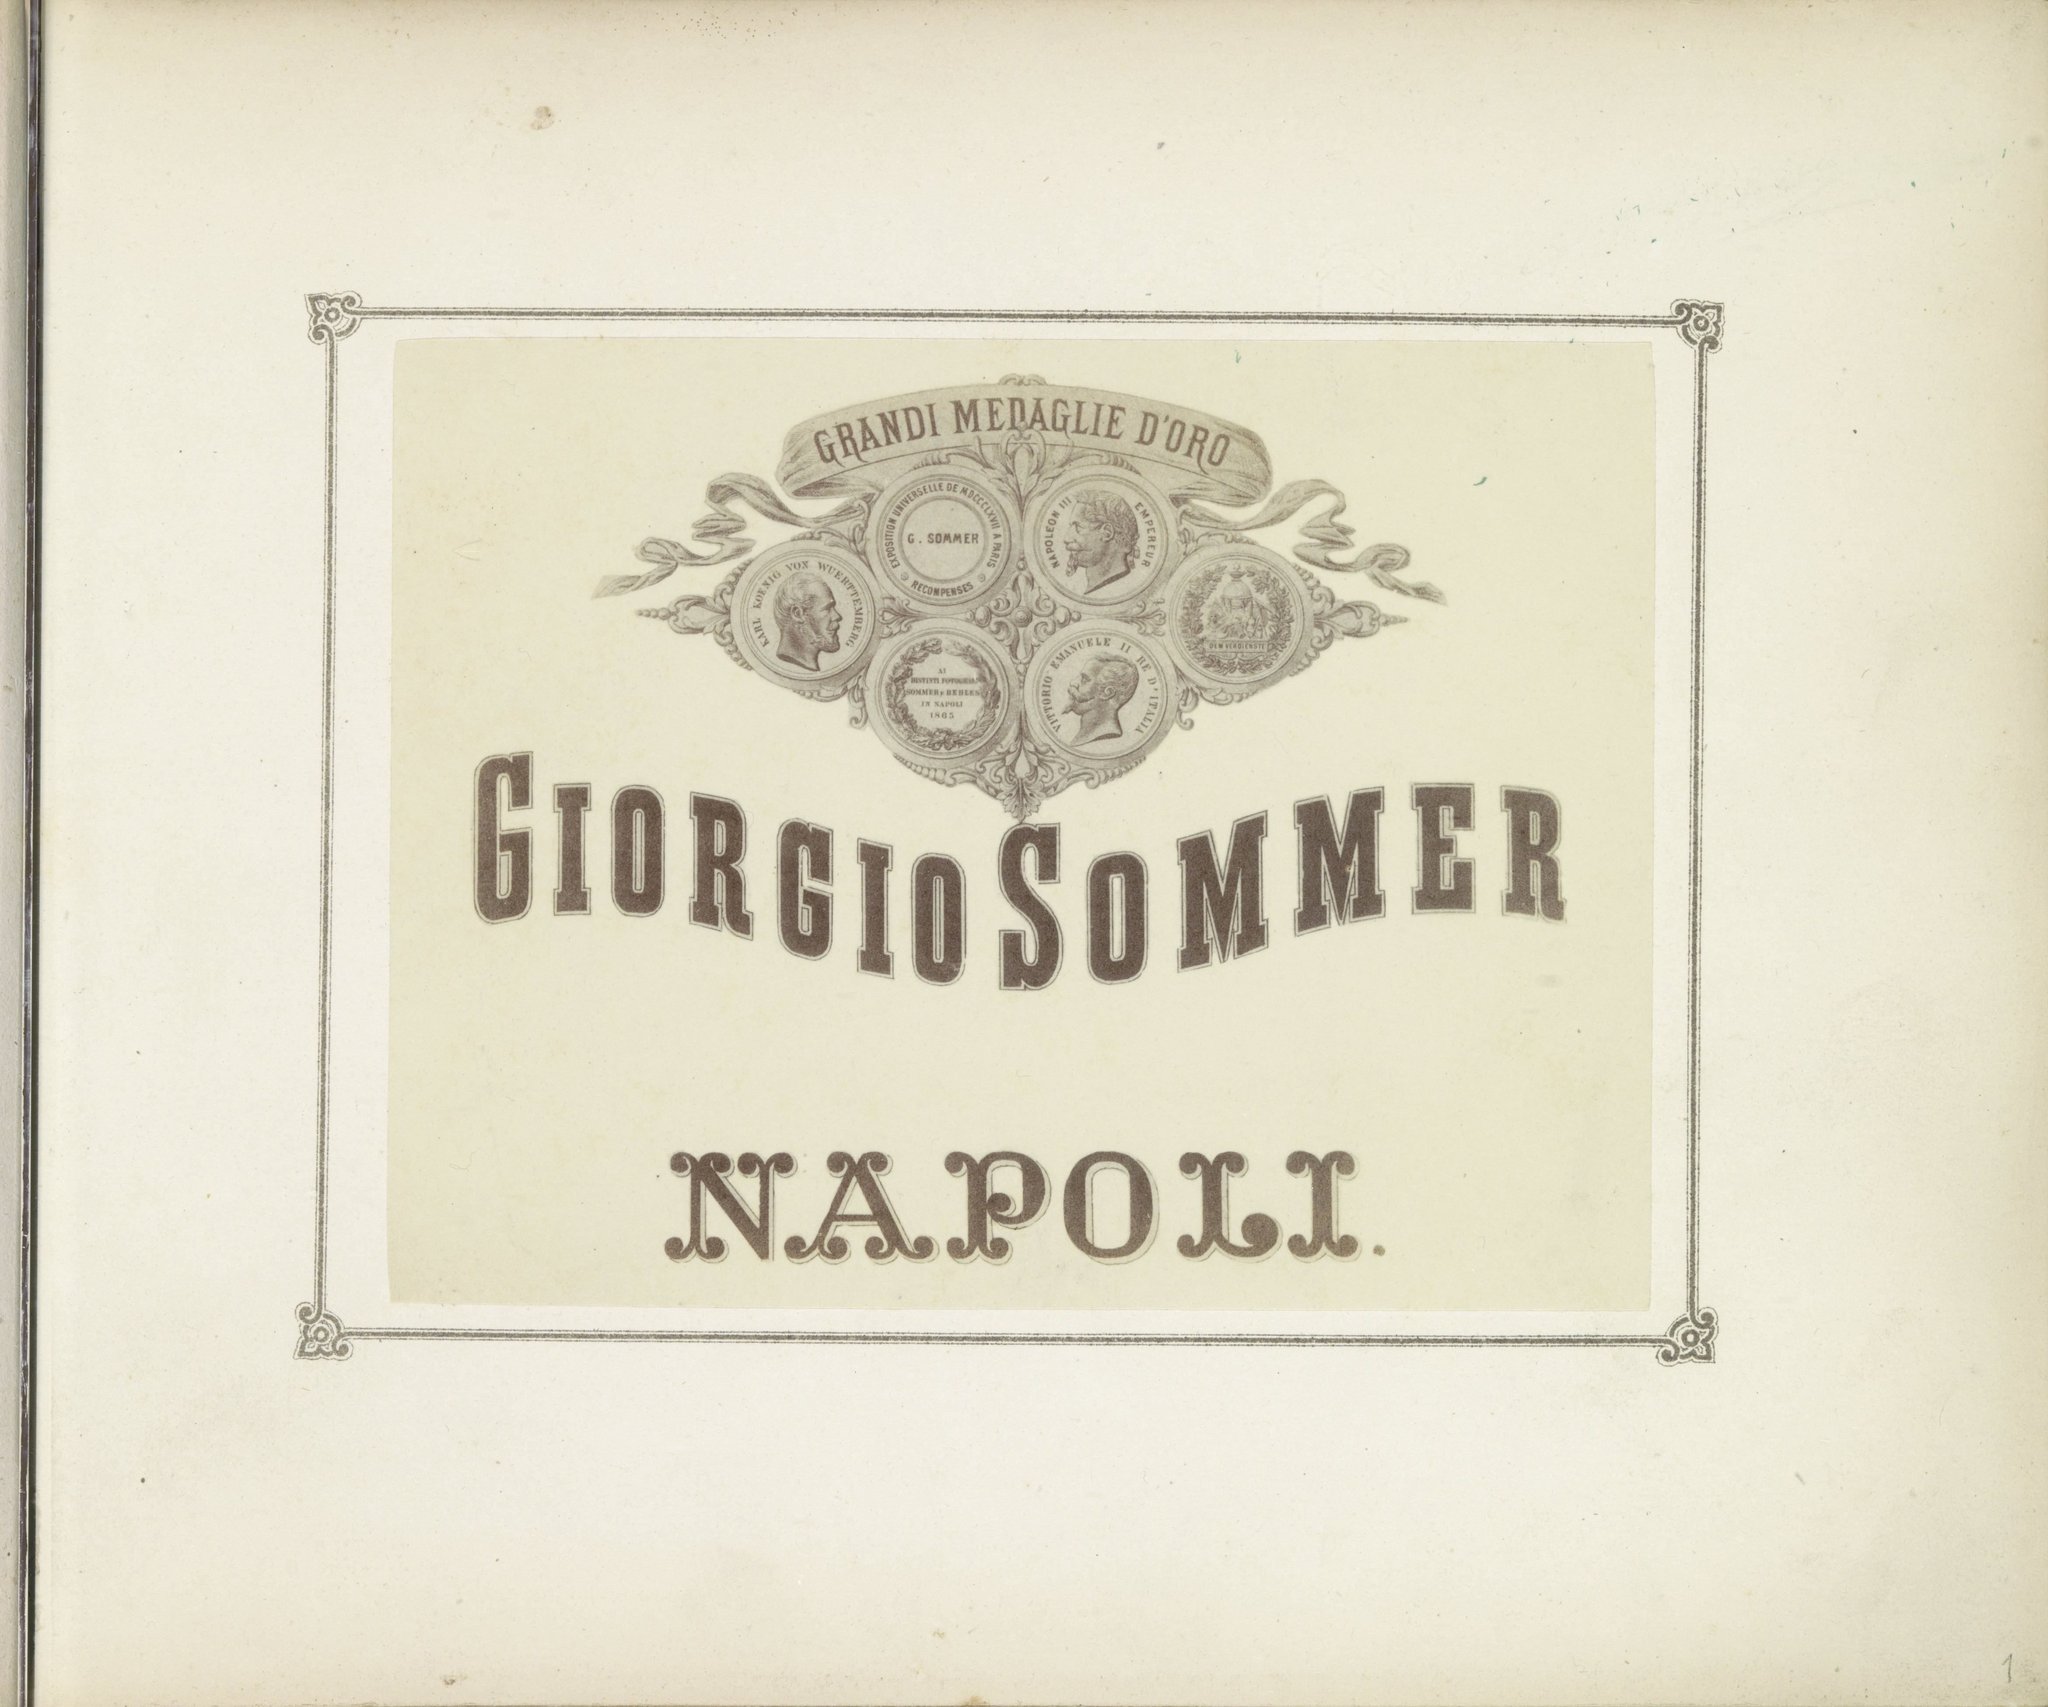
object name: photograph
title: Pagina met de vervaardigersnaam, zijn vestigingsplaats en gewonnen fotografieprijzen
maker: giorgio sommer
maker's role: fotograaf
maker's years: 1834-1914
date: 1860-1900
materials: paper, photographic support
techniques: albumen print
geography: pompeii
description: Onderdeel van Fotoalbum met opnames van opgravingen in Pompeï door Giorgio Sommer.